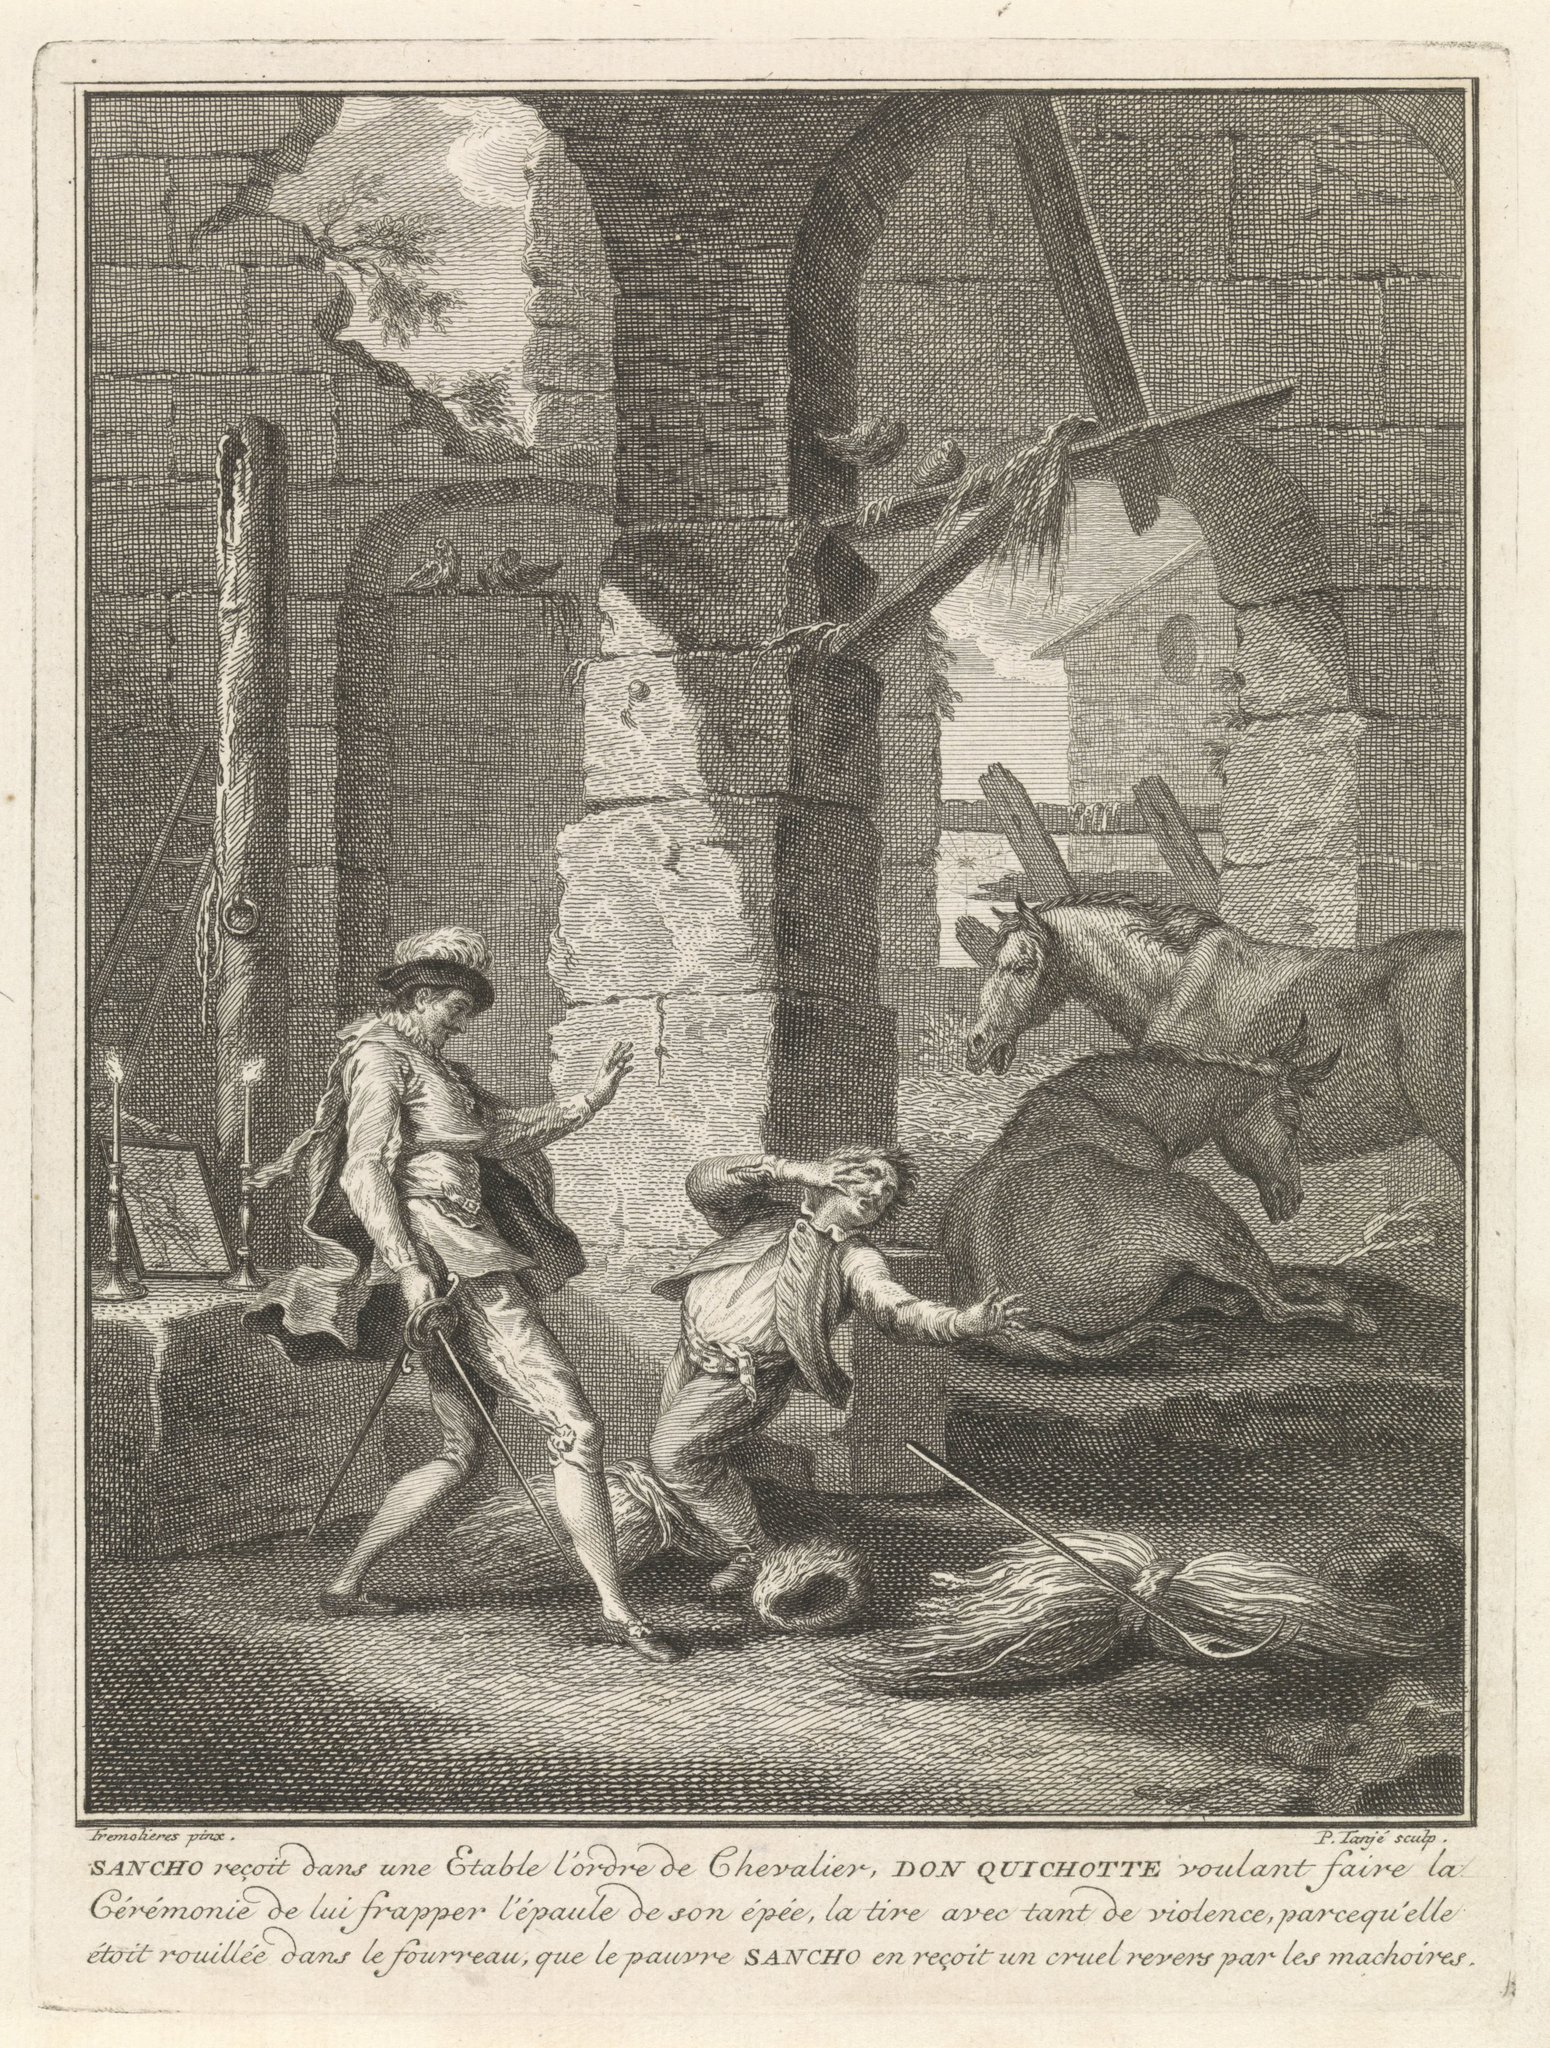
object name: book illustration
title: Sancho Panza wordt door Don Quichotte tot ridder geslagen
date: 1716-1761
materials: paper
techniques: engraving, etching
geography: amsterdam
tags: don quixote, sancho panza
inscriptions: collector's mark: Lugt 2228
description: Prent ook gebruikt als illustratie in: Cervantes y Saavedra, Miguel de. Les principales avantures de l'admirable Don Quichotte, repréntées en figures (...) avec les explications des XXXI planches (...) tirées de l'original espagnol de Miguel de Cervantes. [Vertaald uit het Spaans door] Jacob Campo Weyerman. Den Haag: Pieter de Hondt, 1746.